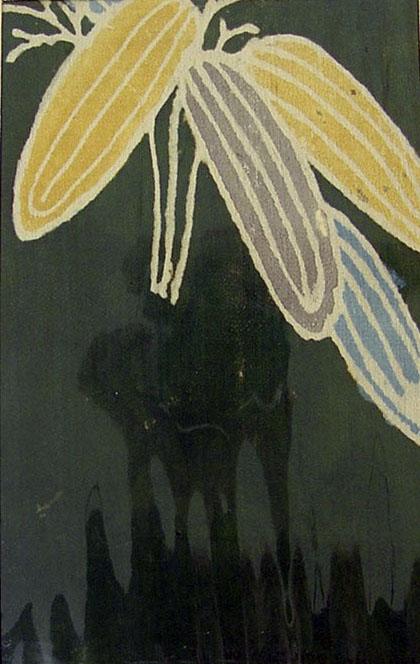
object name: piece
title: Textile with Bamboo Leaves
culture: japanese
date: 1615-1868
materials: silk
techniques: dyeing, painting, weave, resist